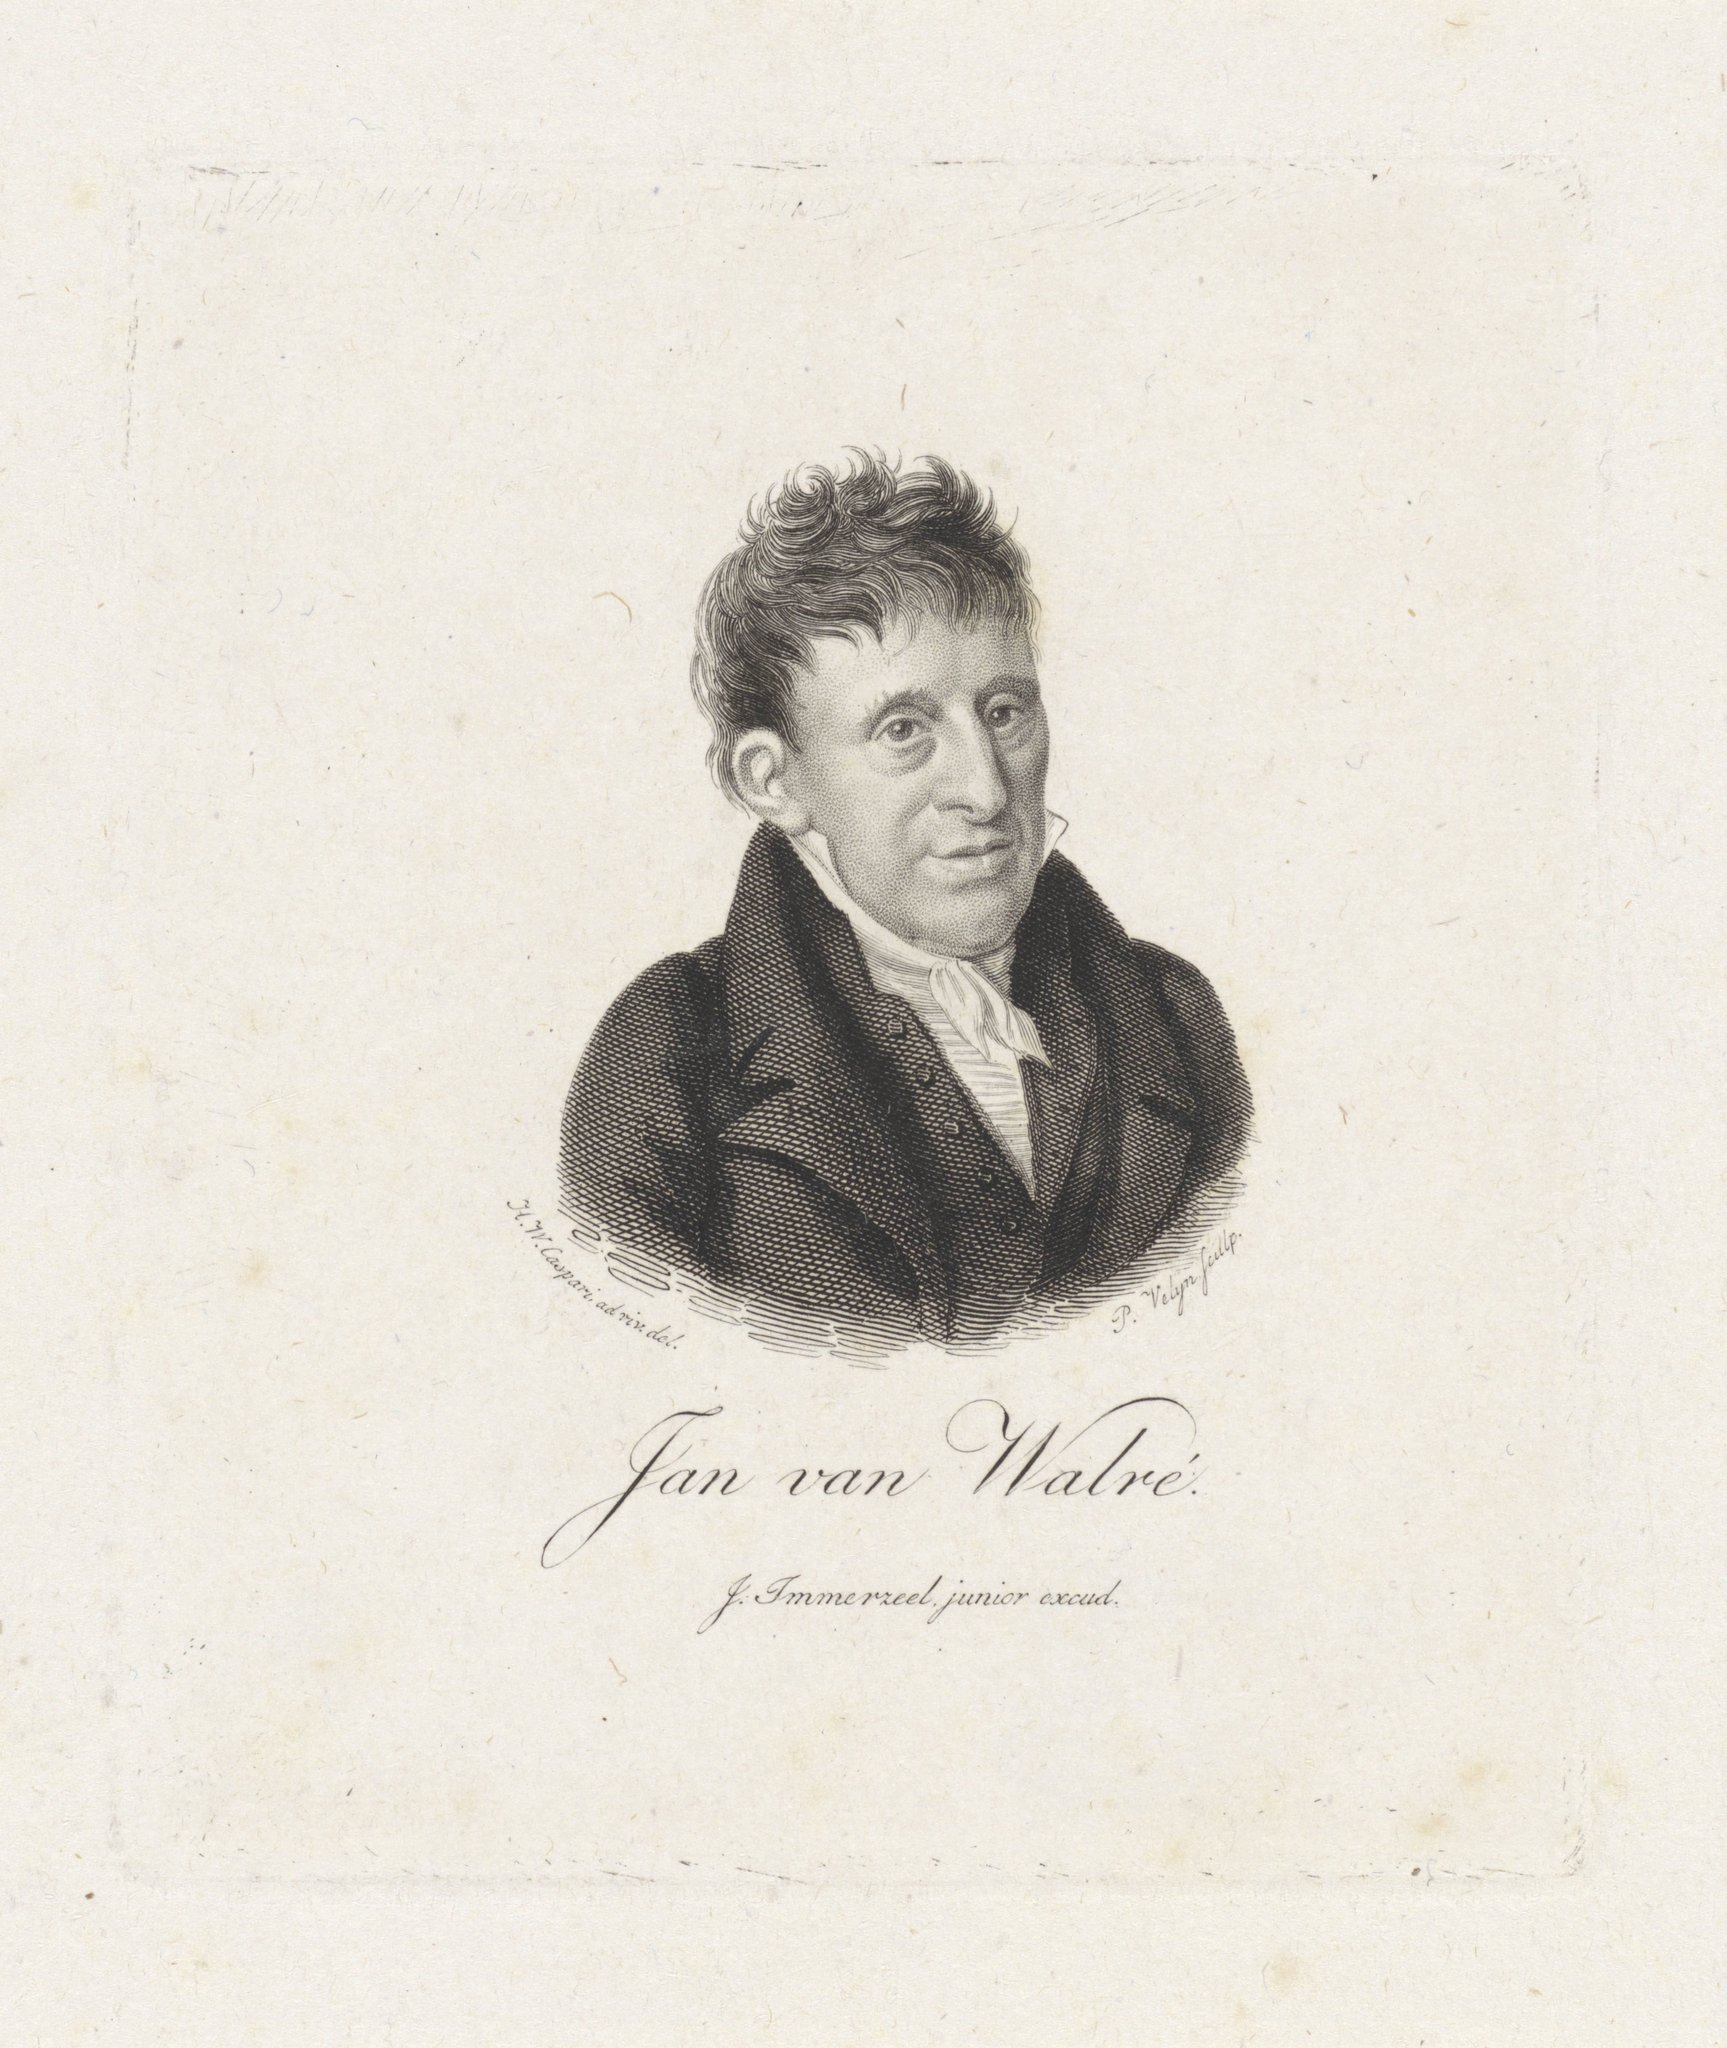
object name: print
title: Portret van Jan van Walré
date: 1826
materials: paper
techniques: engraving, etching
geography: netherlands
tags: haarlem, publisher, jan van walré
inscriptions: collector's mark: Lugt 2228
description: Prent volgens Van Someren ook gebruikt in: Nederlandsche Muzen-Almanak. Rotterdam: J. Immerzeel, 1826.